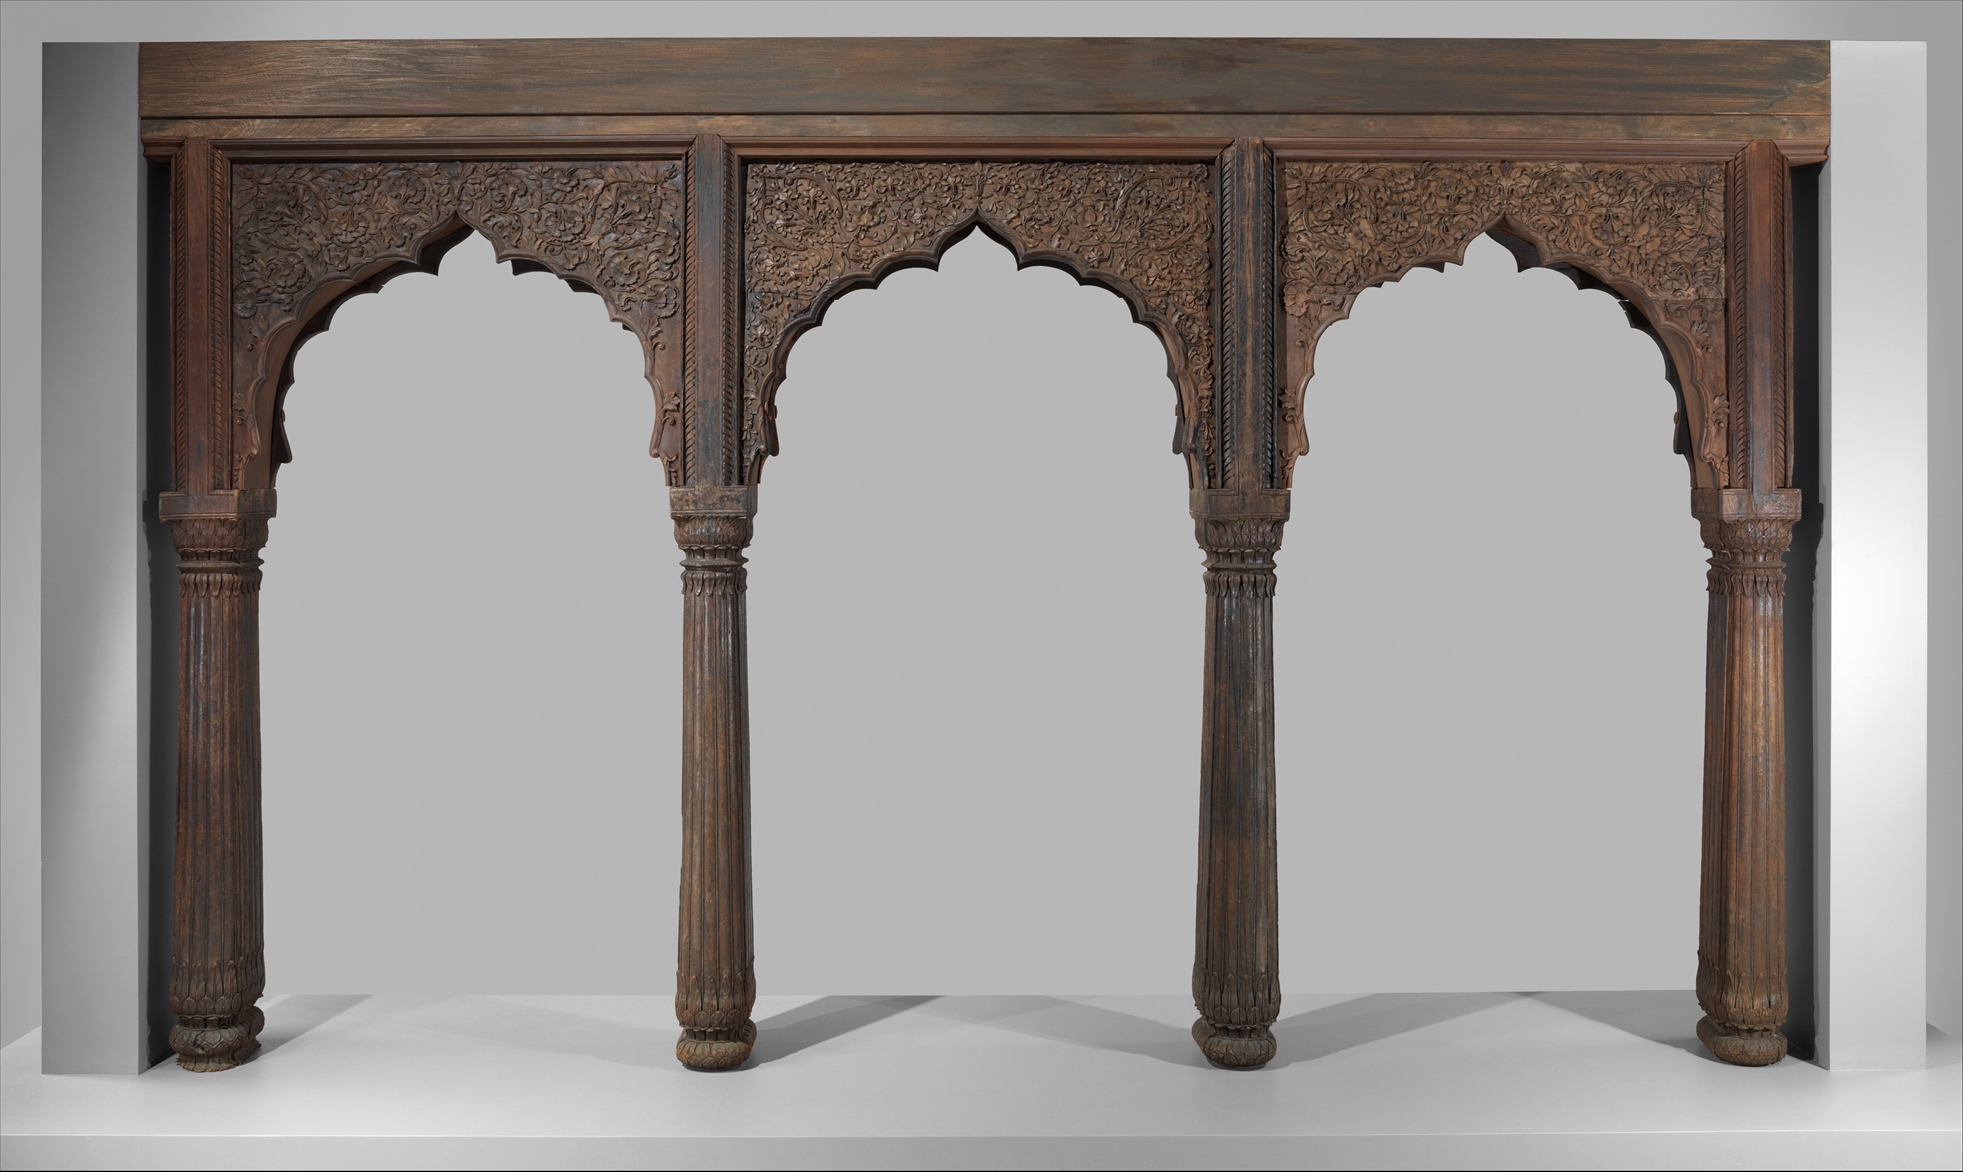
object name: arch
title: Three Arches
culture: indian, northern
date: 1667-1700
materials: wood